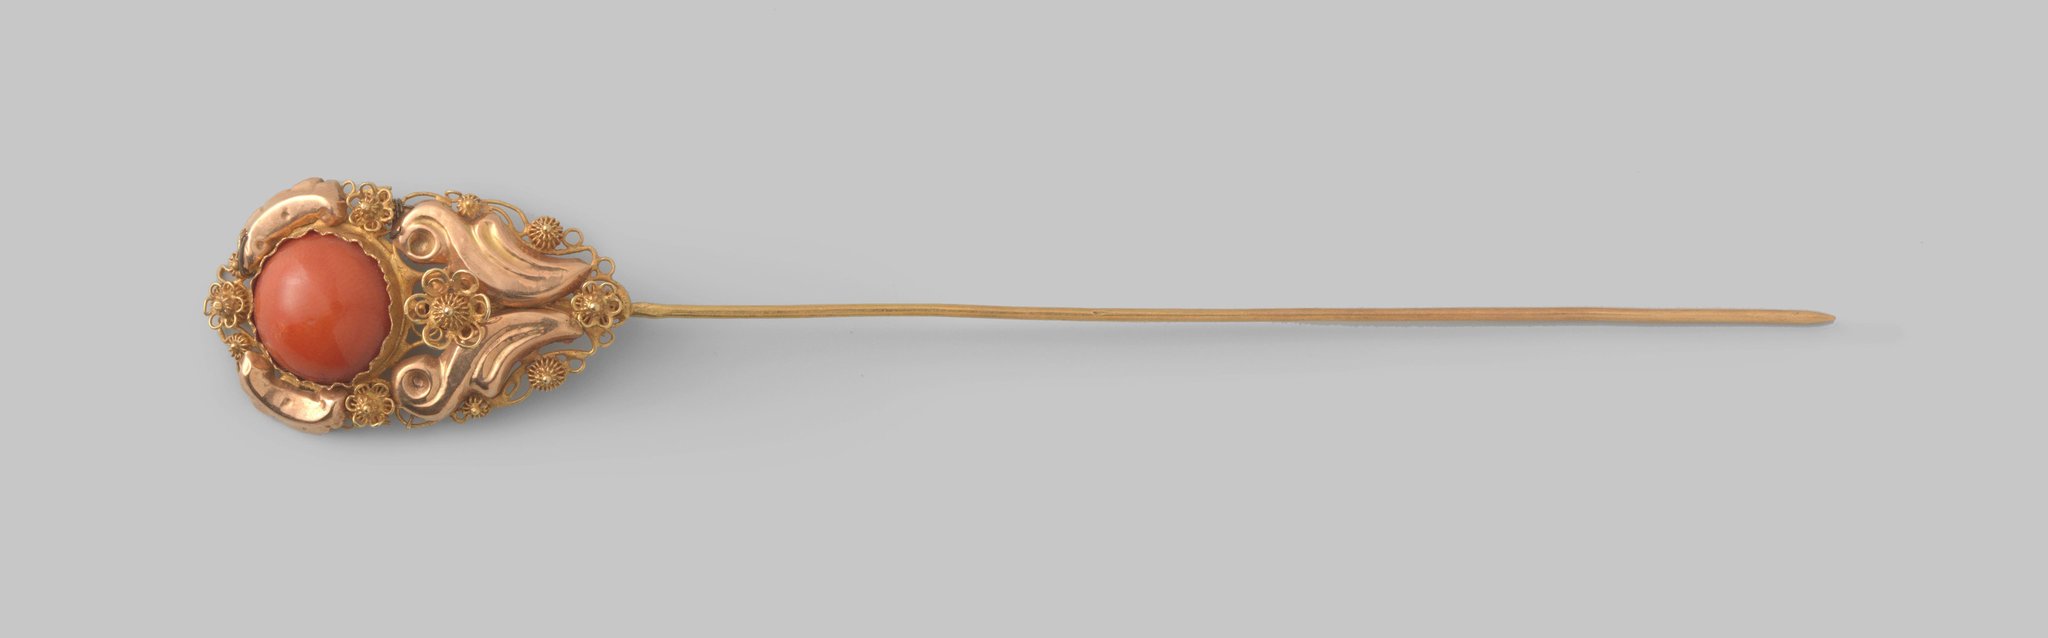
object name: kapstel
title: Gouden staanspeld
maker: jacobus carrenhoff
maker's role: silversmith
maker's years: 1771-1848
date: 1785-1800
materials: gold, coral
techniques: filigree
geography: zaanstreek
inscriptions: mark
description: Gouden staanspeld versierd met een bloedkoraal in een gouden zetting met filigrein rozetten. Afkomstig van een Oud-Zaans kapstel. Gemerkt J.C.H.